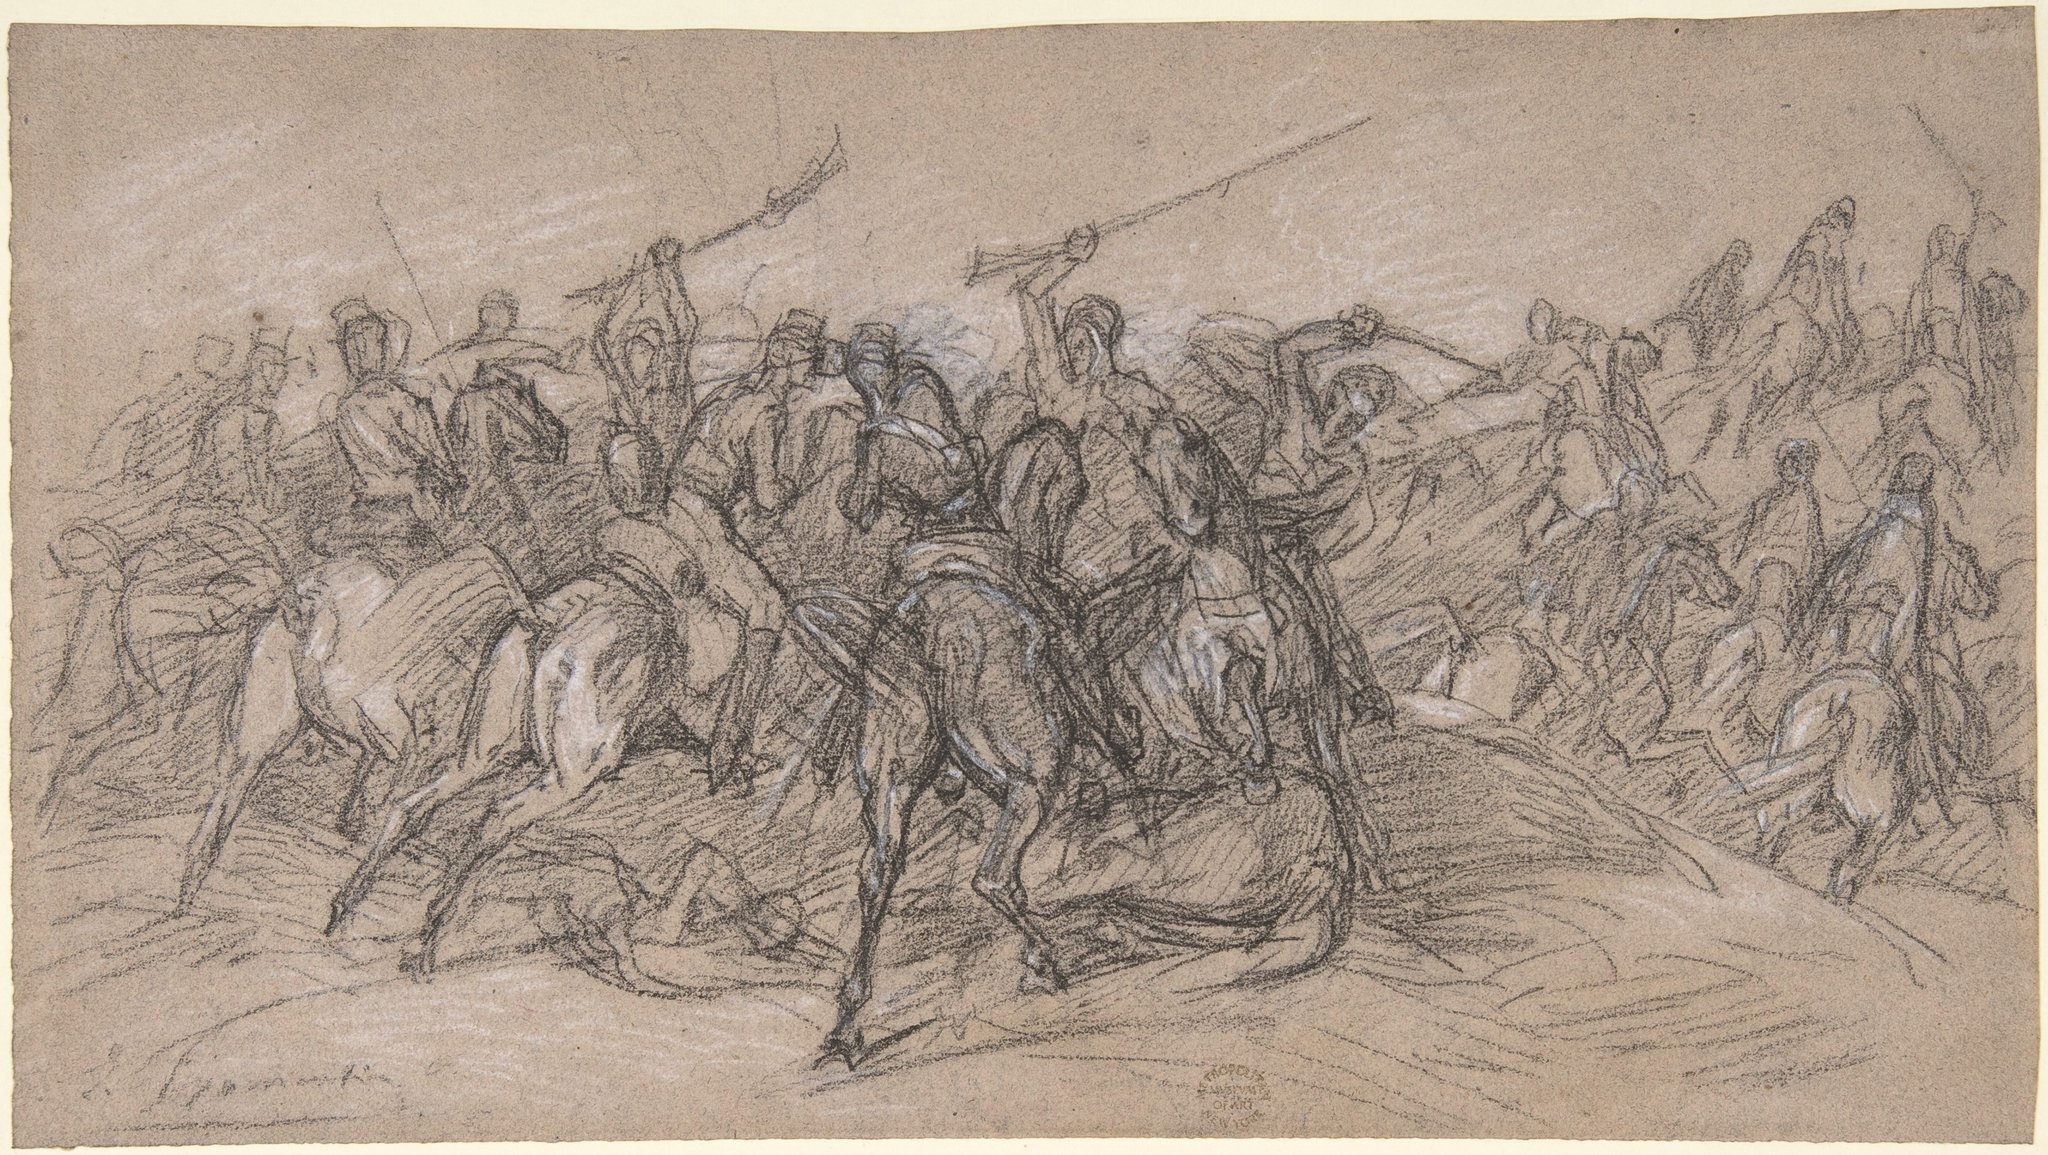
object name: drawing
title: Arab Skirmish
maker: eugène fromentin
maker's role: artist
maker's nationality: french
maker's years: 1820-1876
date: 1801-1900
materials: chalk, paper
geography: france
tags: human figures,battles,weapons,horses